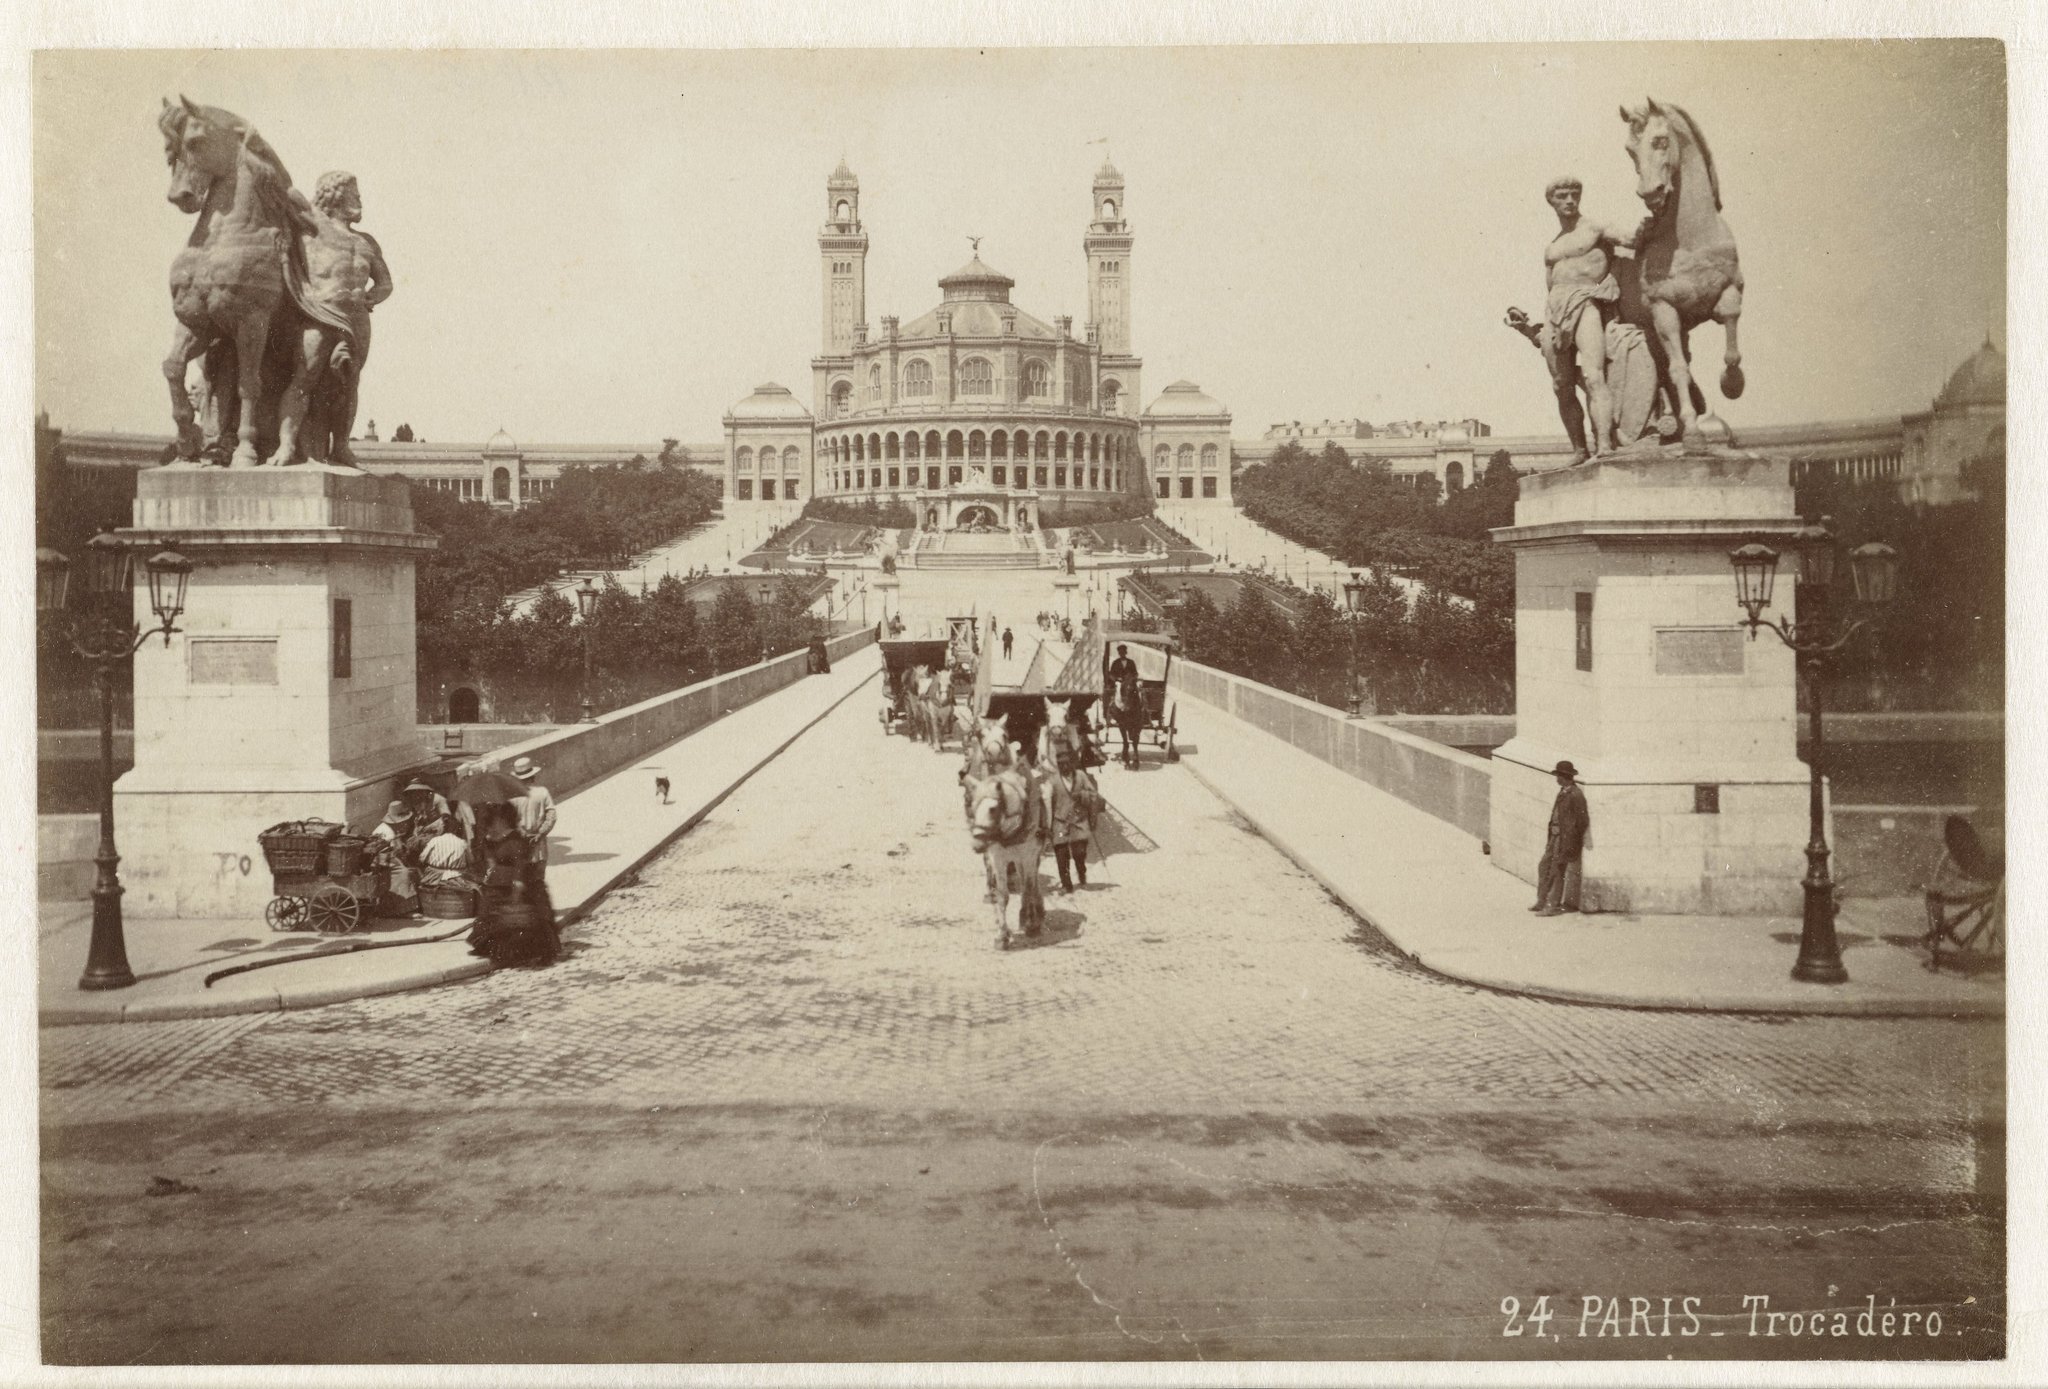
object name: photograph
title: Gezicht op het Palais du Trocadéro in Parijs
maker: Anonymous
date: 1867-1900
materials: paper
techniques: albumen print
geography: paris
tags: palace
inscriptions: address: ‘Jules HAUTECOEUR,/ PARIS,/ 172, Rue de Rivoli.’, number: ‘24.’